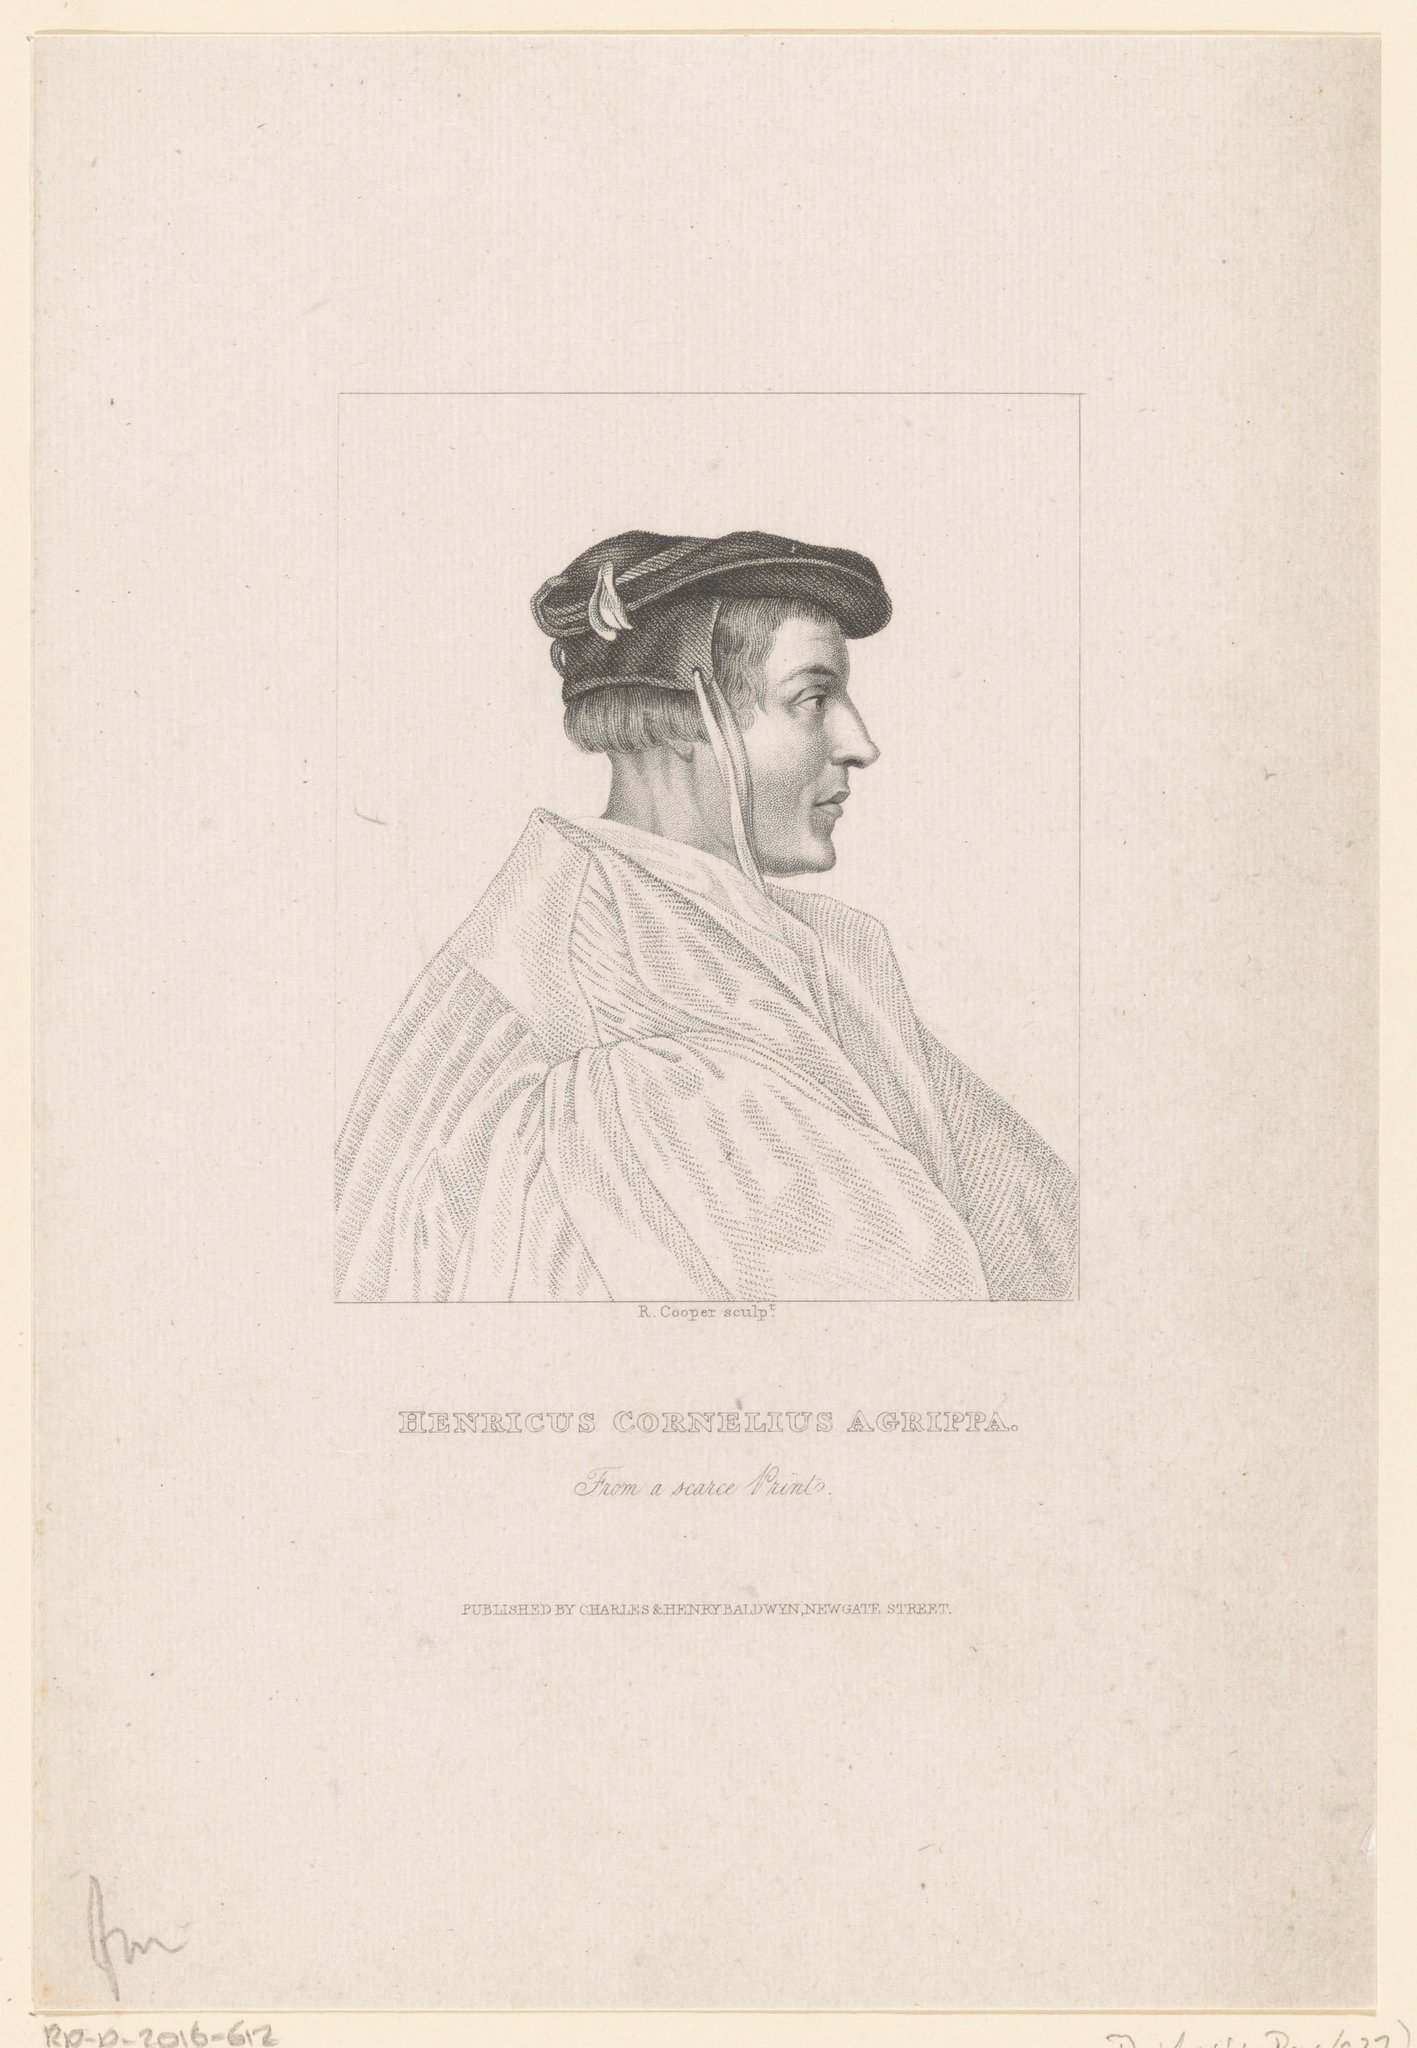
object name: print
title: Portret van Henricus Cornelius Agrippa von Nettesheim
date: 1795-1839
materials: paper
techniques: etching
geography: london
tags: cologne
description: Portret van Henricus Cornelius Agrippa von Nettesheim in een rechthoekige omlijsting. In de ondermarge zijn naam.